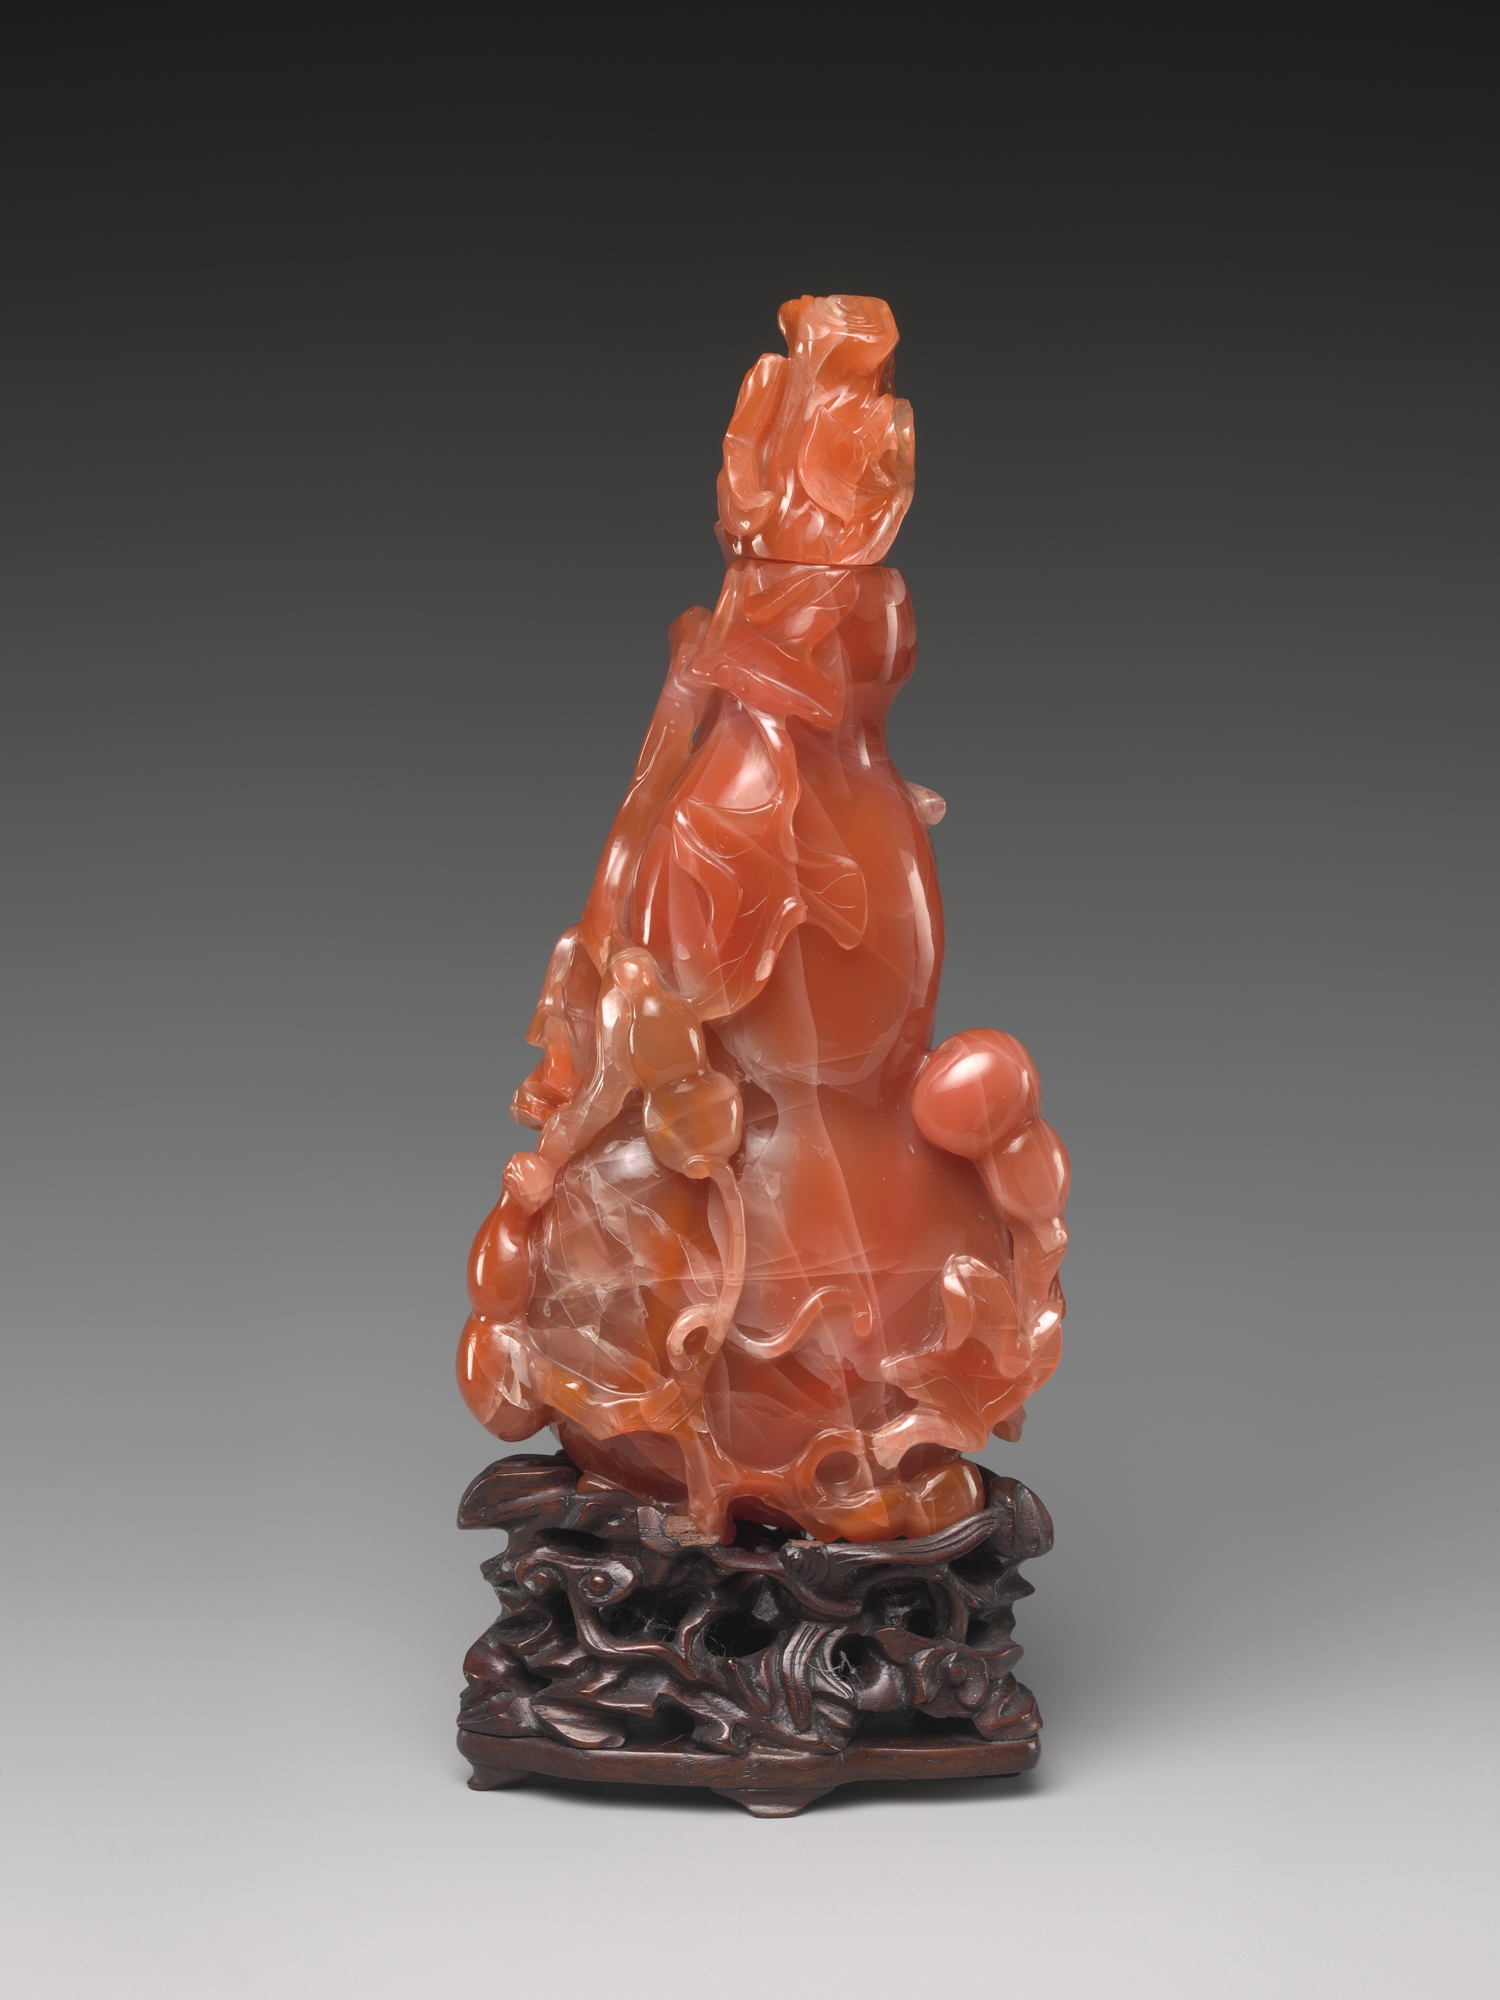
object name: bottle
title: Bottle in the shape of a double gourd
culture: chinese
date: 1801-1900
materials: gemstone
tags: gourds